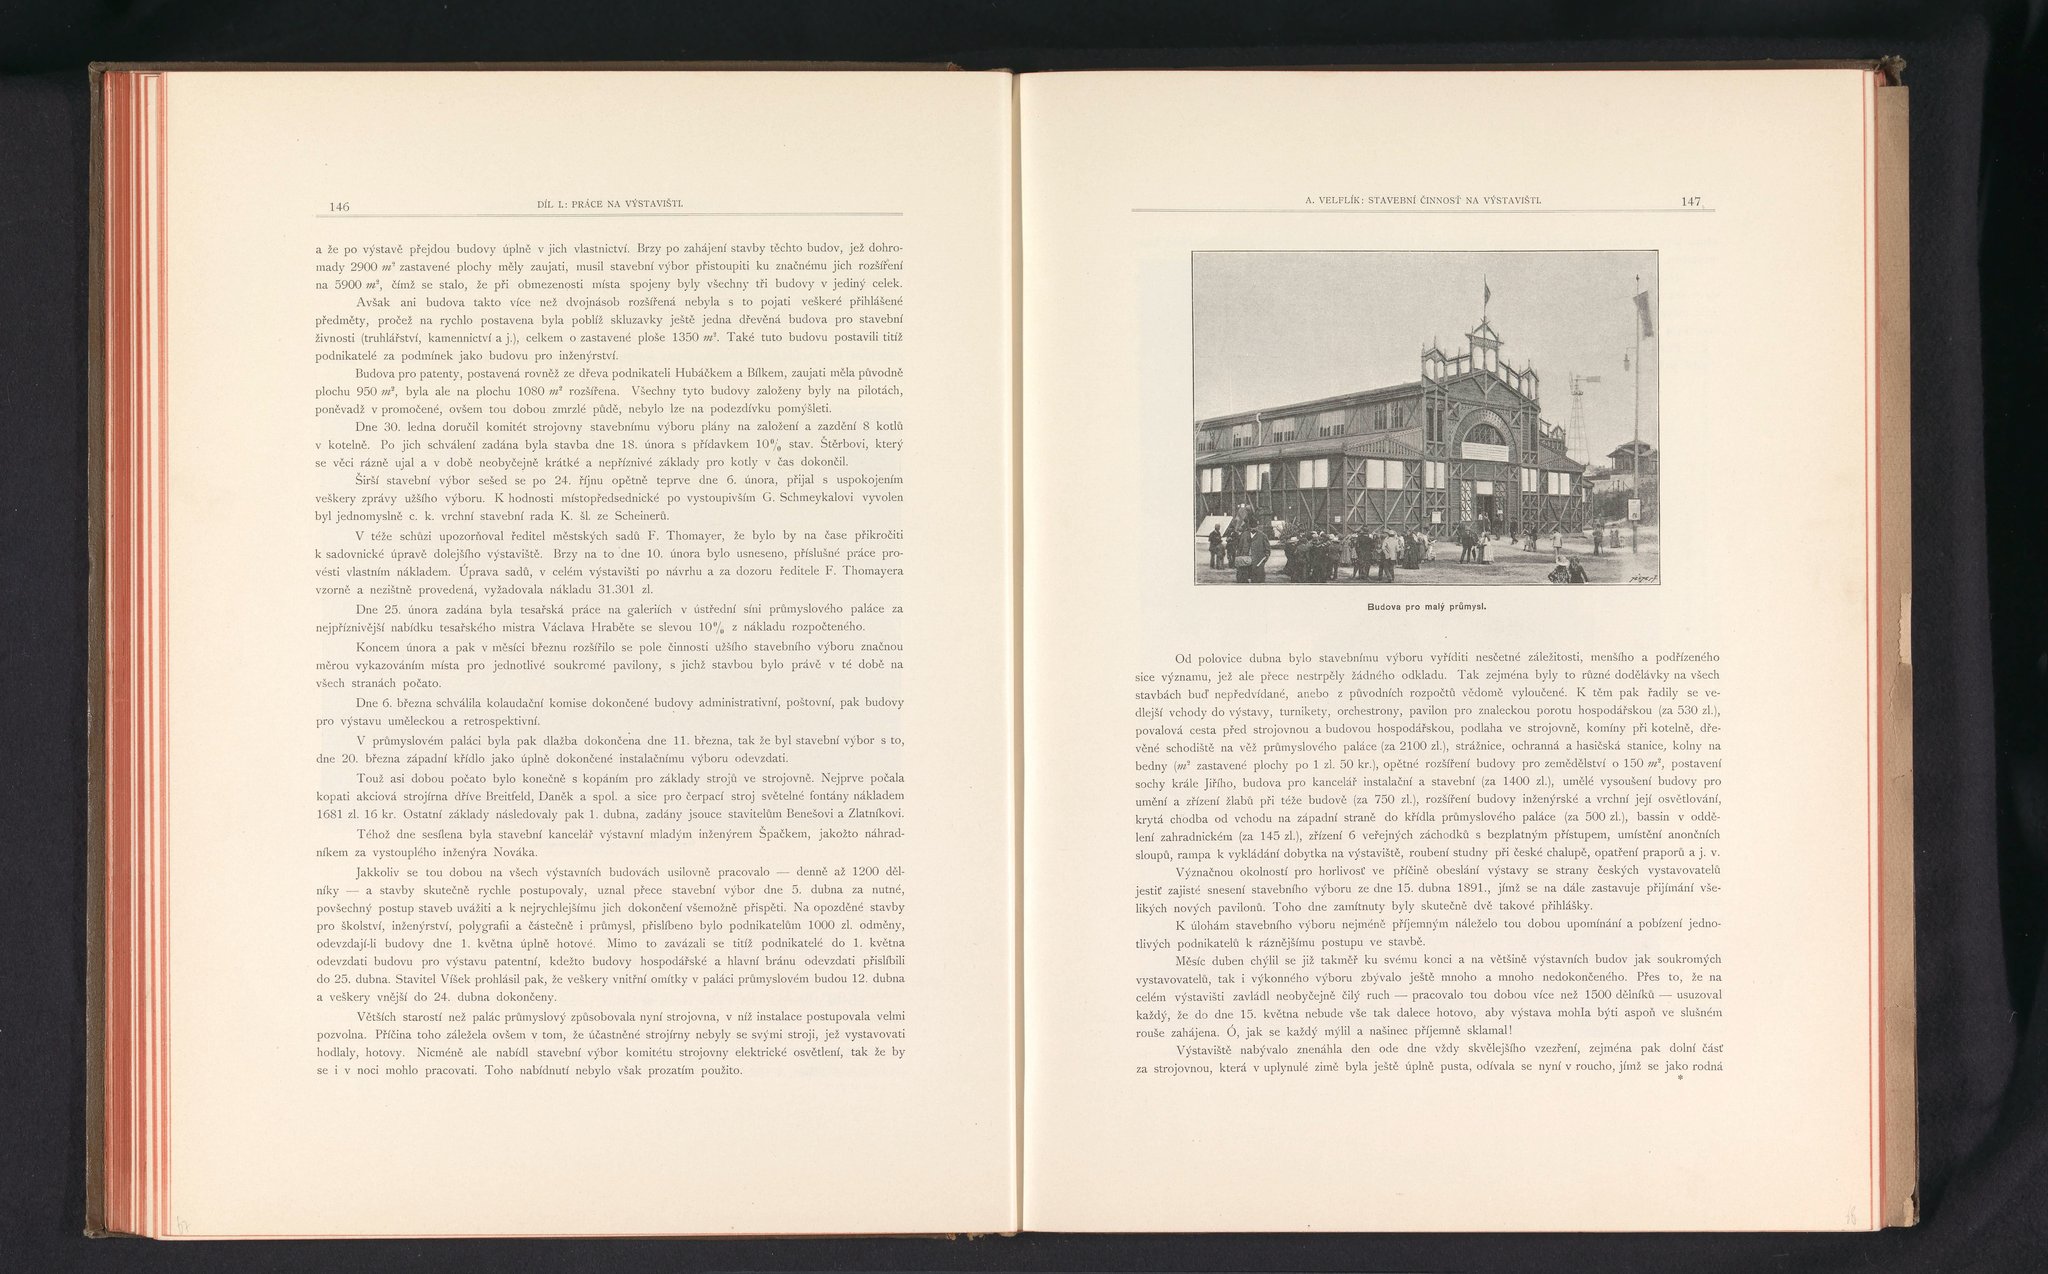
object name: page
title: Budova pro malý prumysi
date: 1888-1893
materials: paper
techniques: autotype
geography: výstaviště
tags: façade (of house or building), temporary exhibition, 'salon'